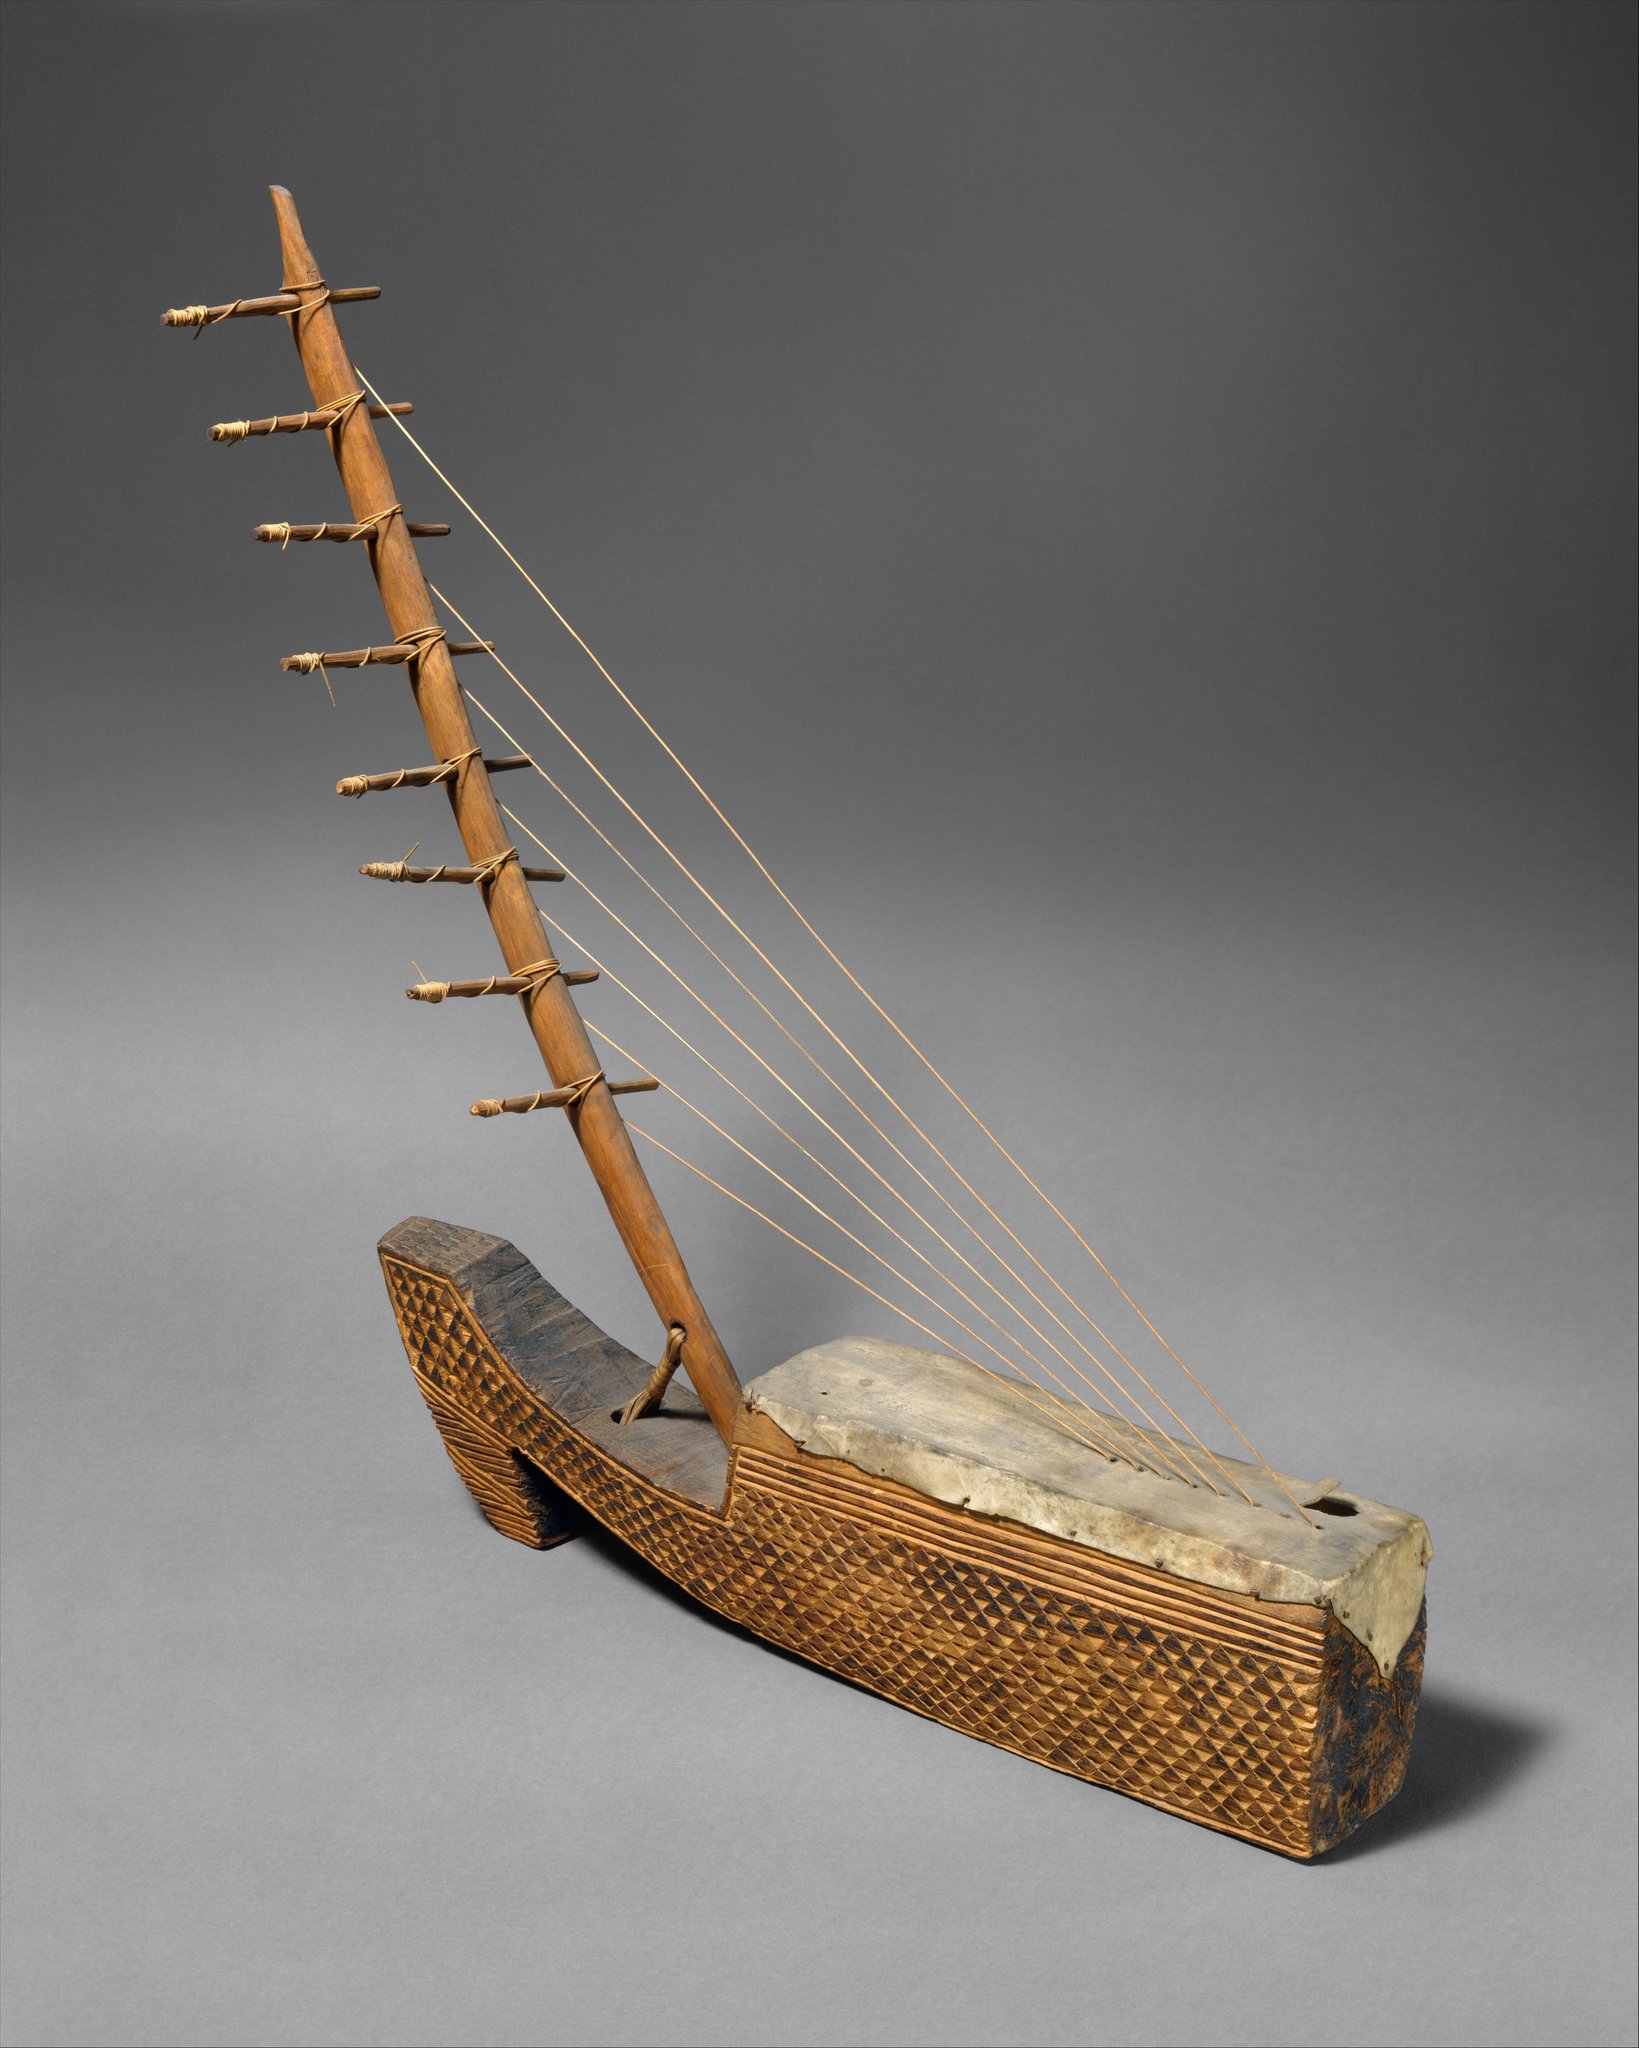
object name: ngombi arched harp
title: Ngombi (arched Harp)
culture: fang or kele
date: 1801-1900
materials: fiber, leather, skin, wood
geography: gabon